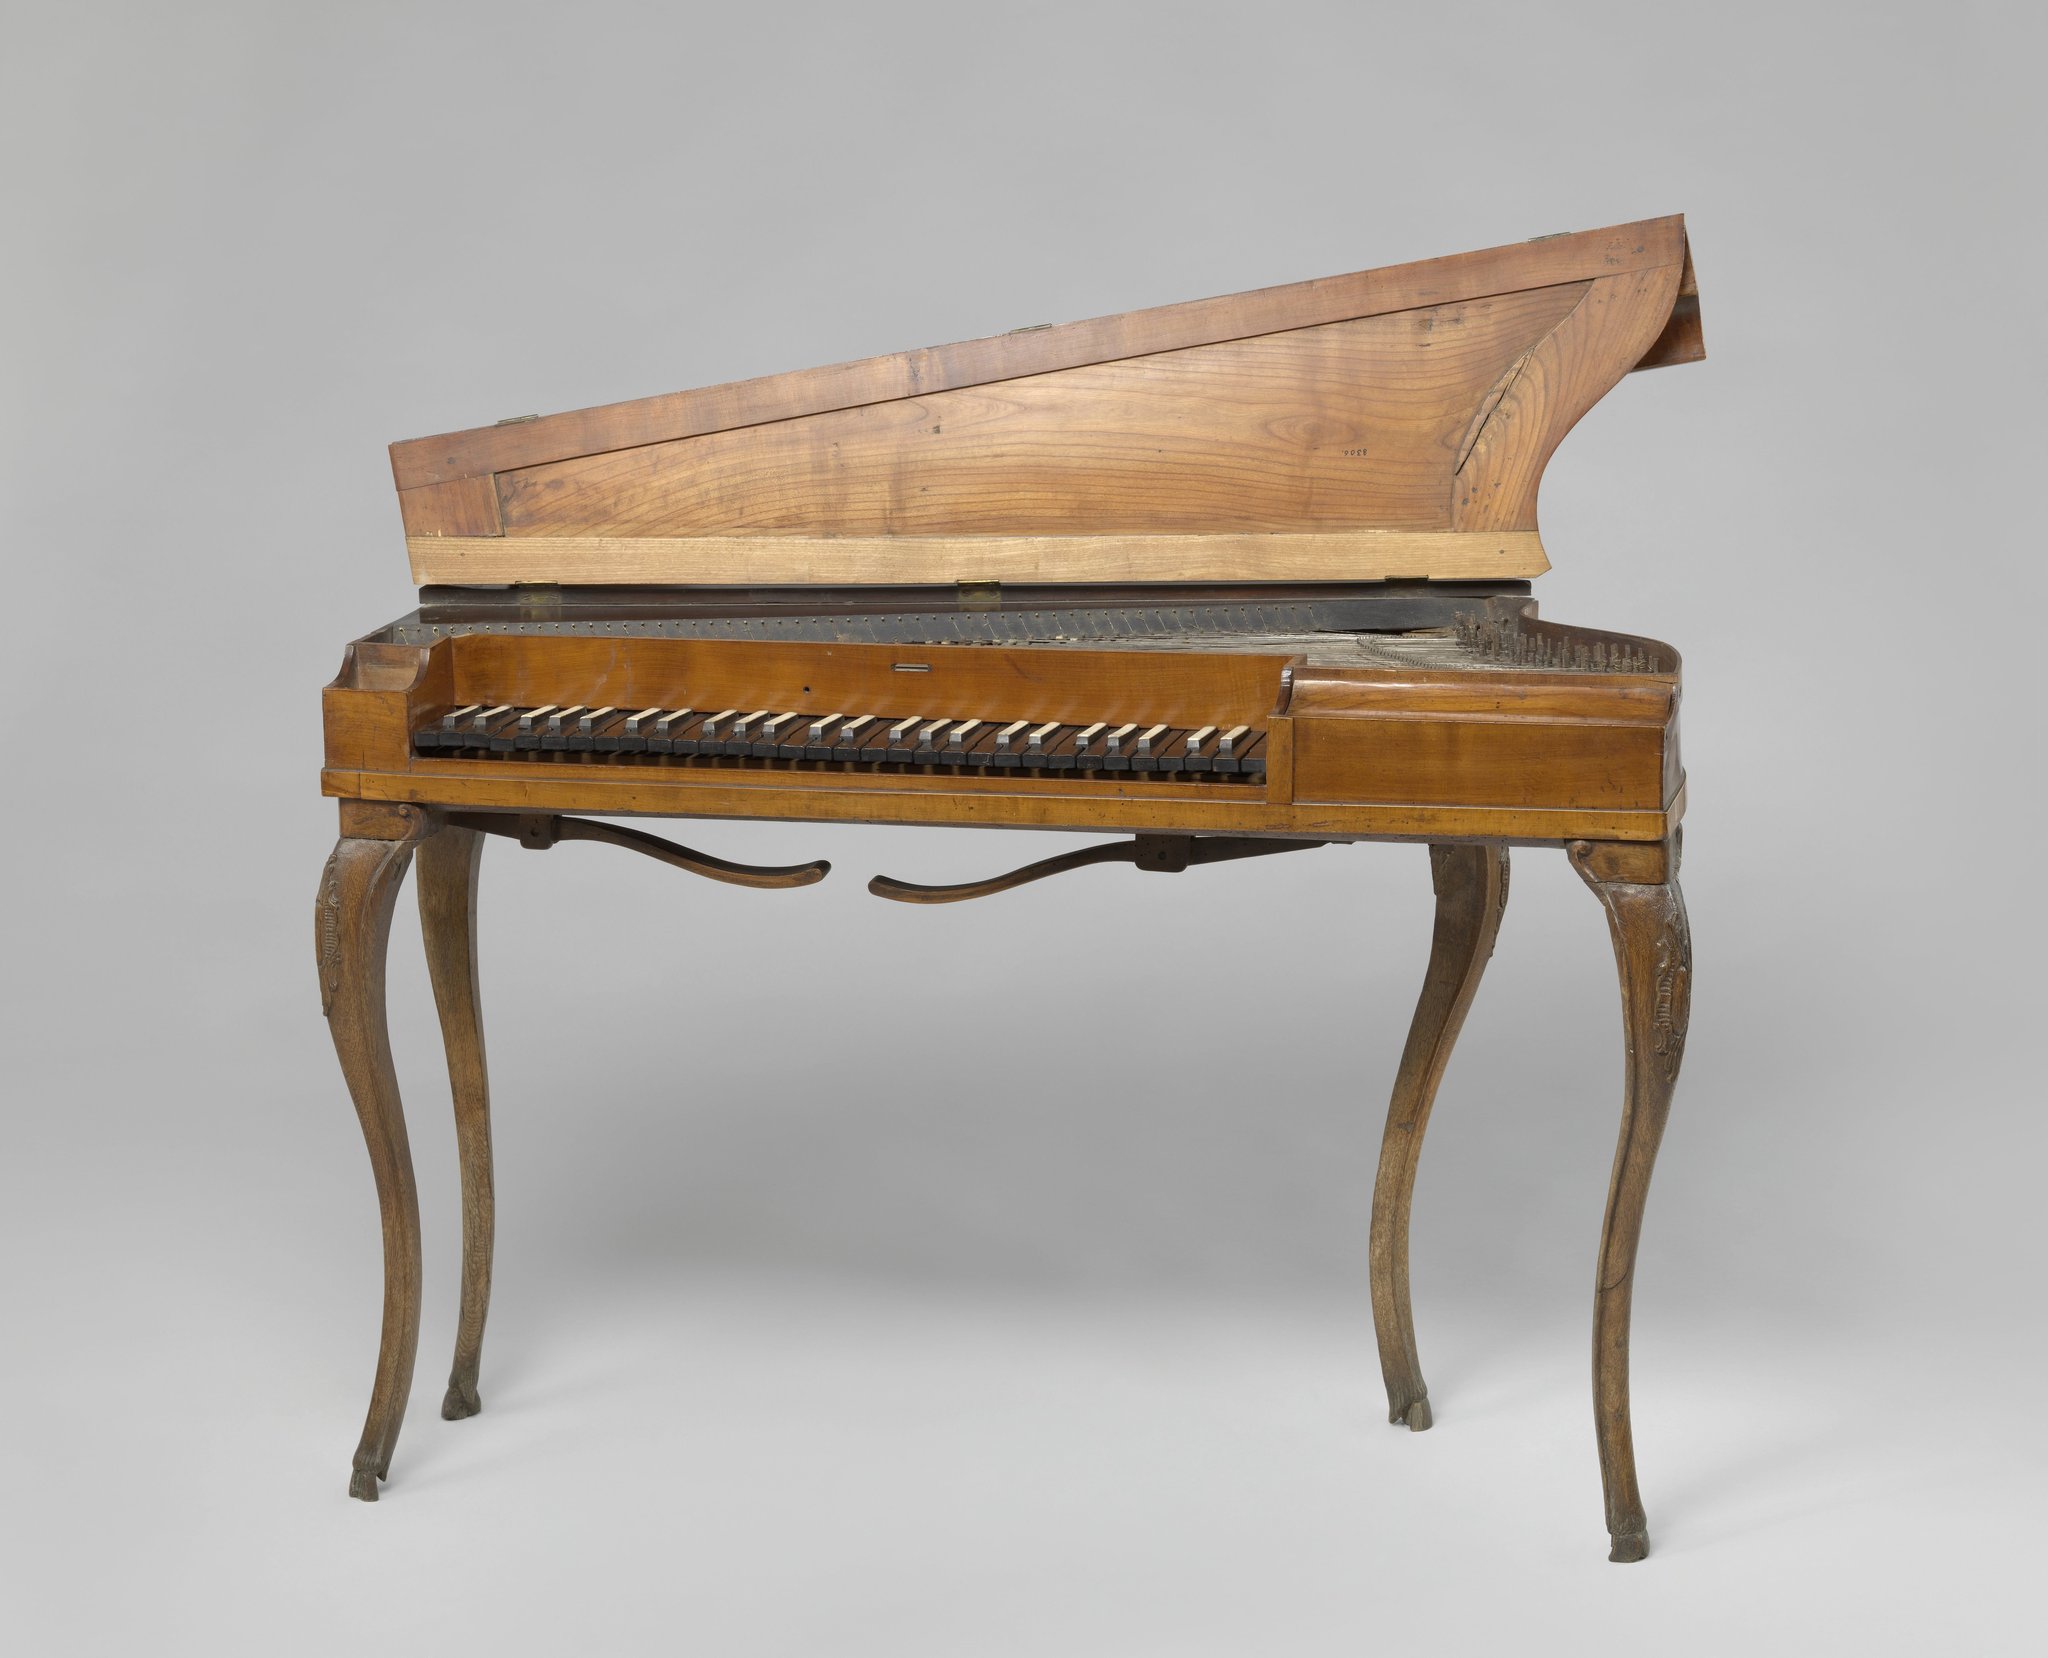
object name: pianoforte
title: Lying-harp piano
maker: Anonymous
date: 1770-1775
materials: brass, wood, iron, ivory, leather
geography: southern germany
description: Small pianos, rectangular or shaped like a spinet, were in existence already before grand pianos became generally known. They were also invented independently of the grand piano, even though grand pianos were appreciated at European courts, for instance that of Medici, throughout the 18th century. Many early small German pianos, including this one, had tiny, bare wooden hammer heads.